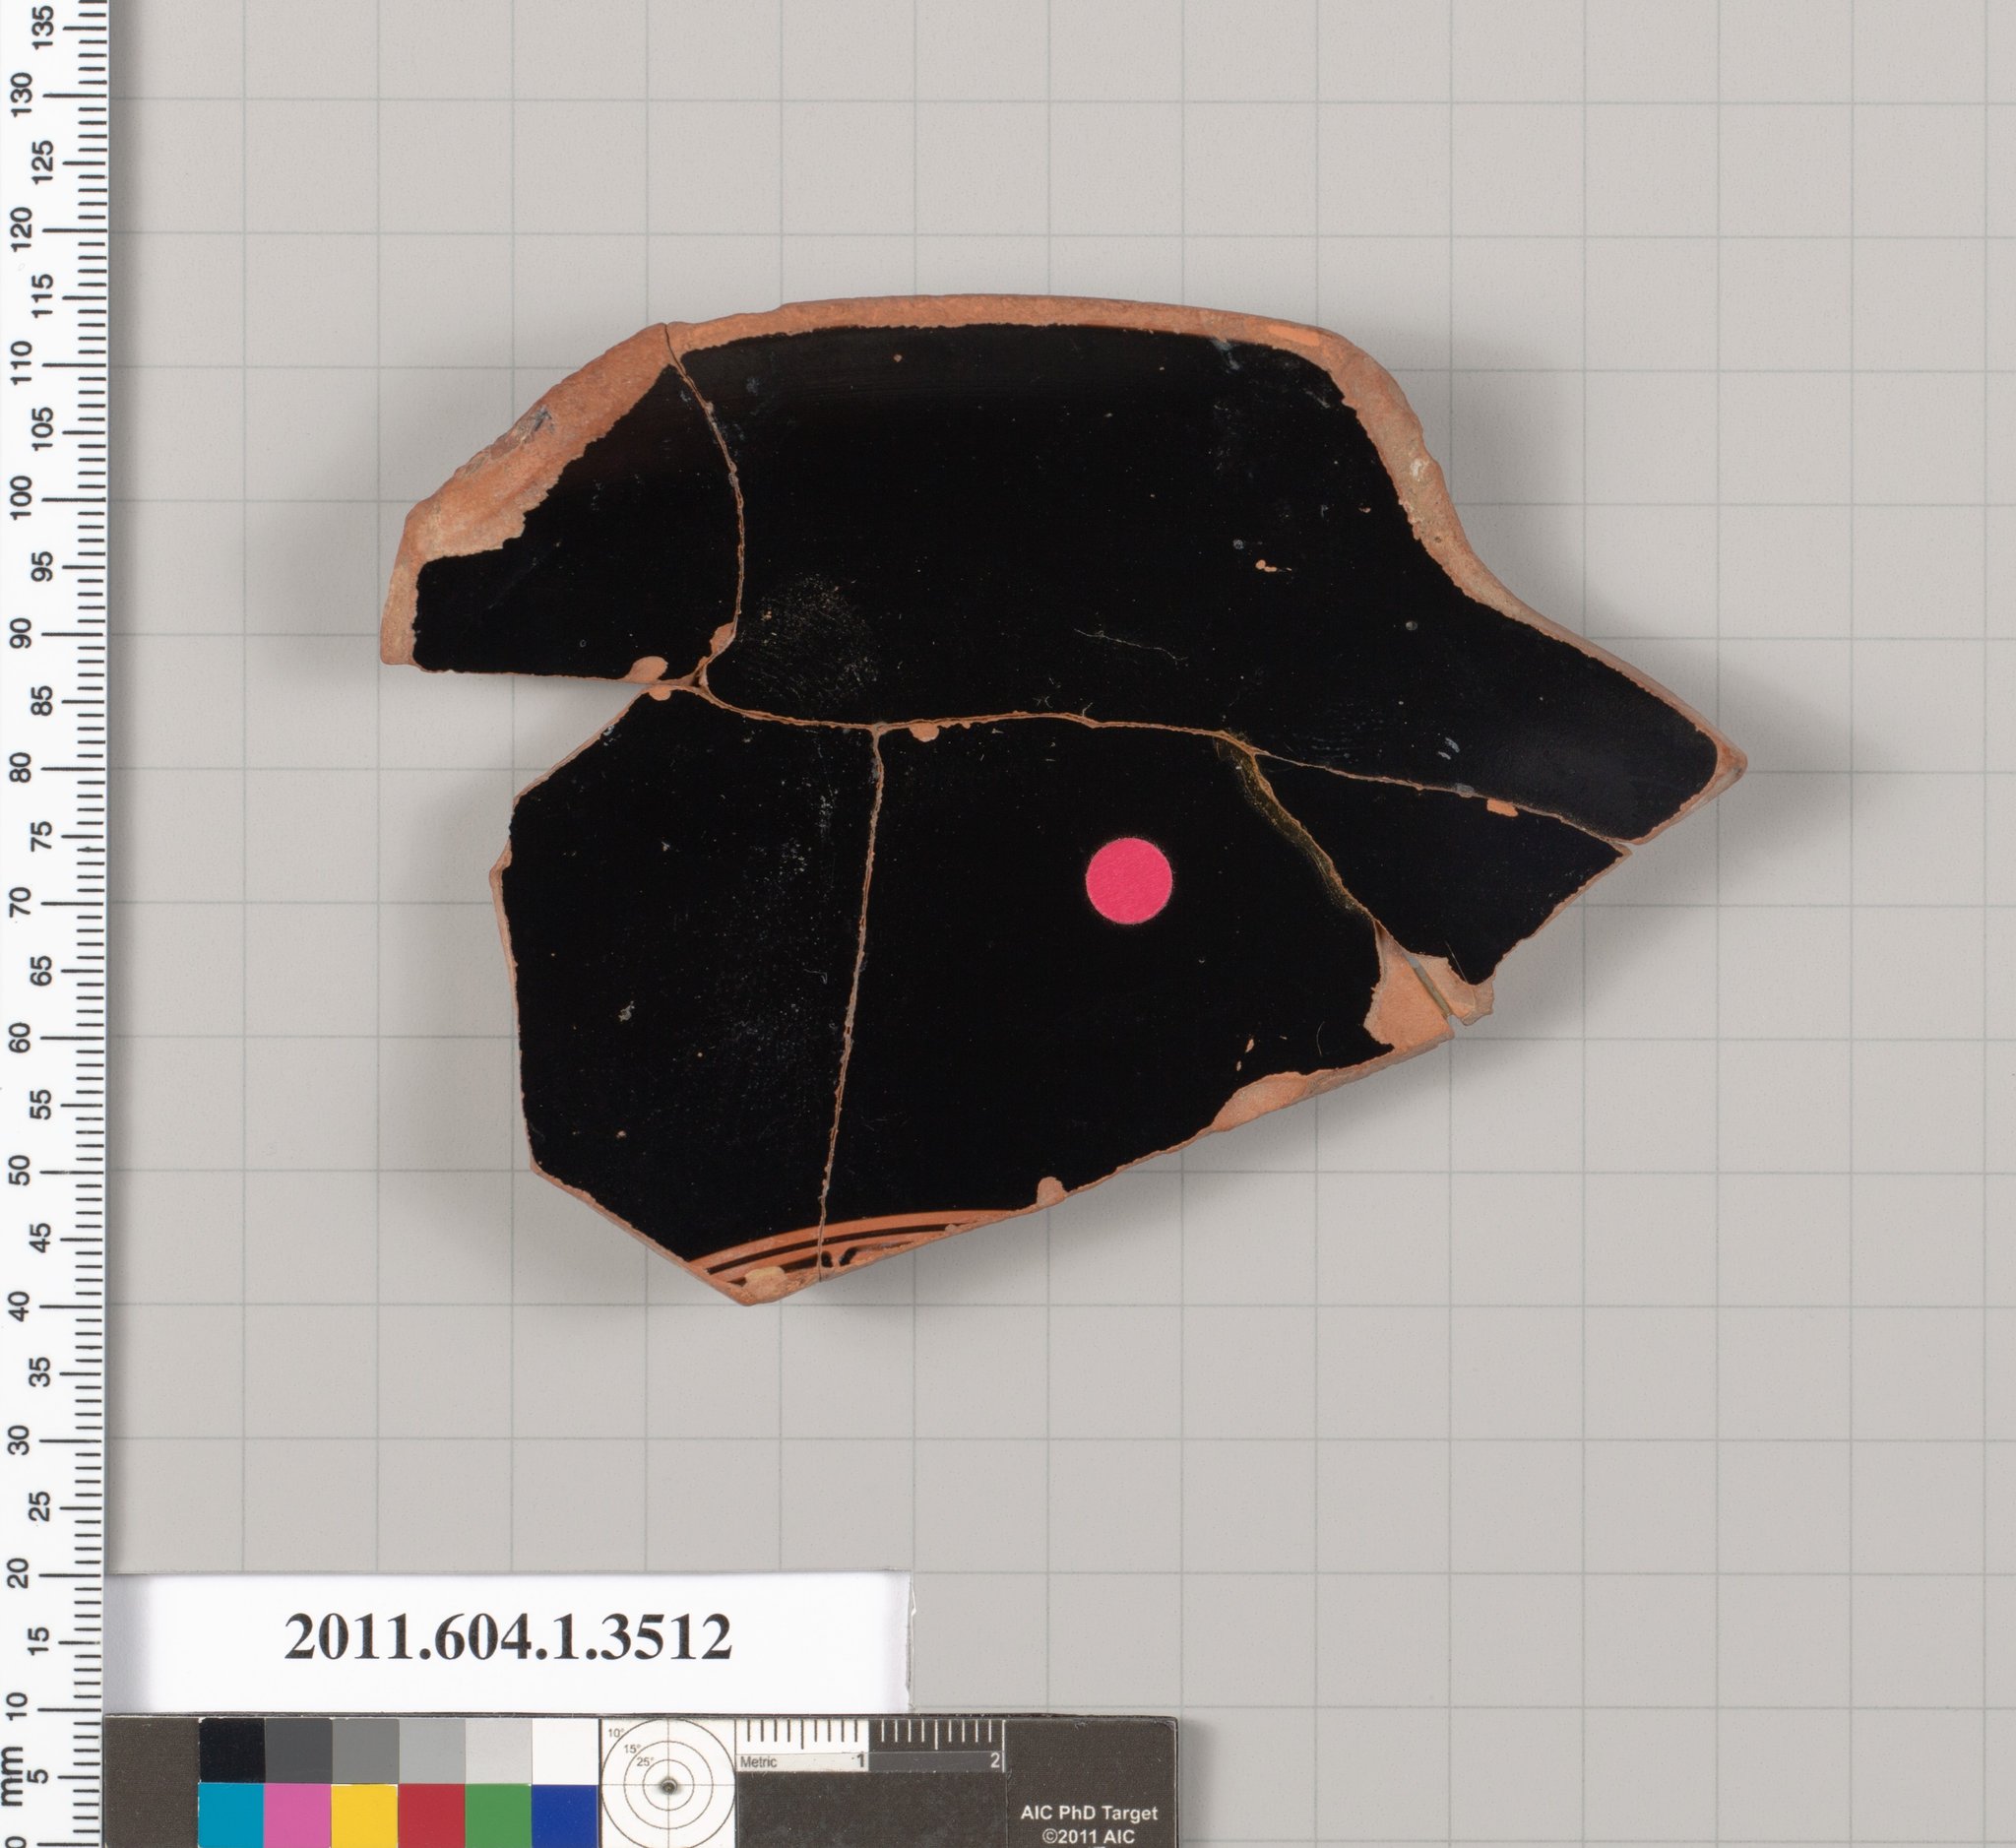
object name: kylix fragment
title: Terracotta rim fragment of a kylix (drinking cup)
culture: greek, attic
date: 480-460 BCE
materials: terracotta